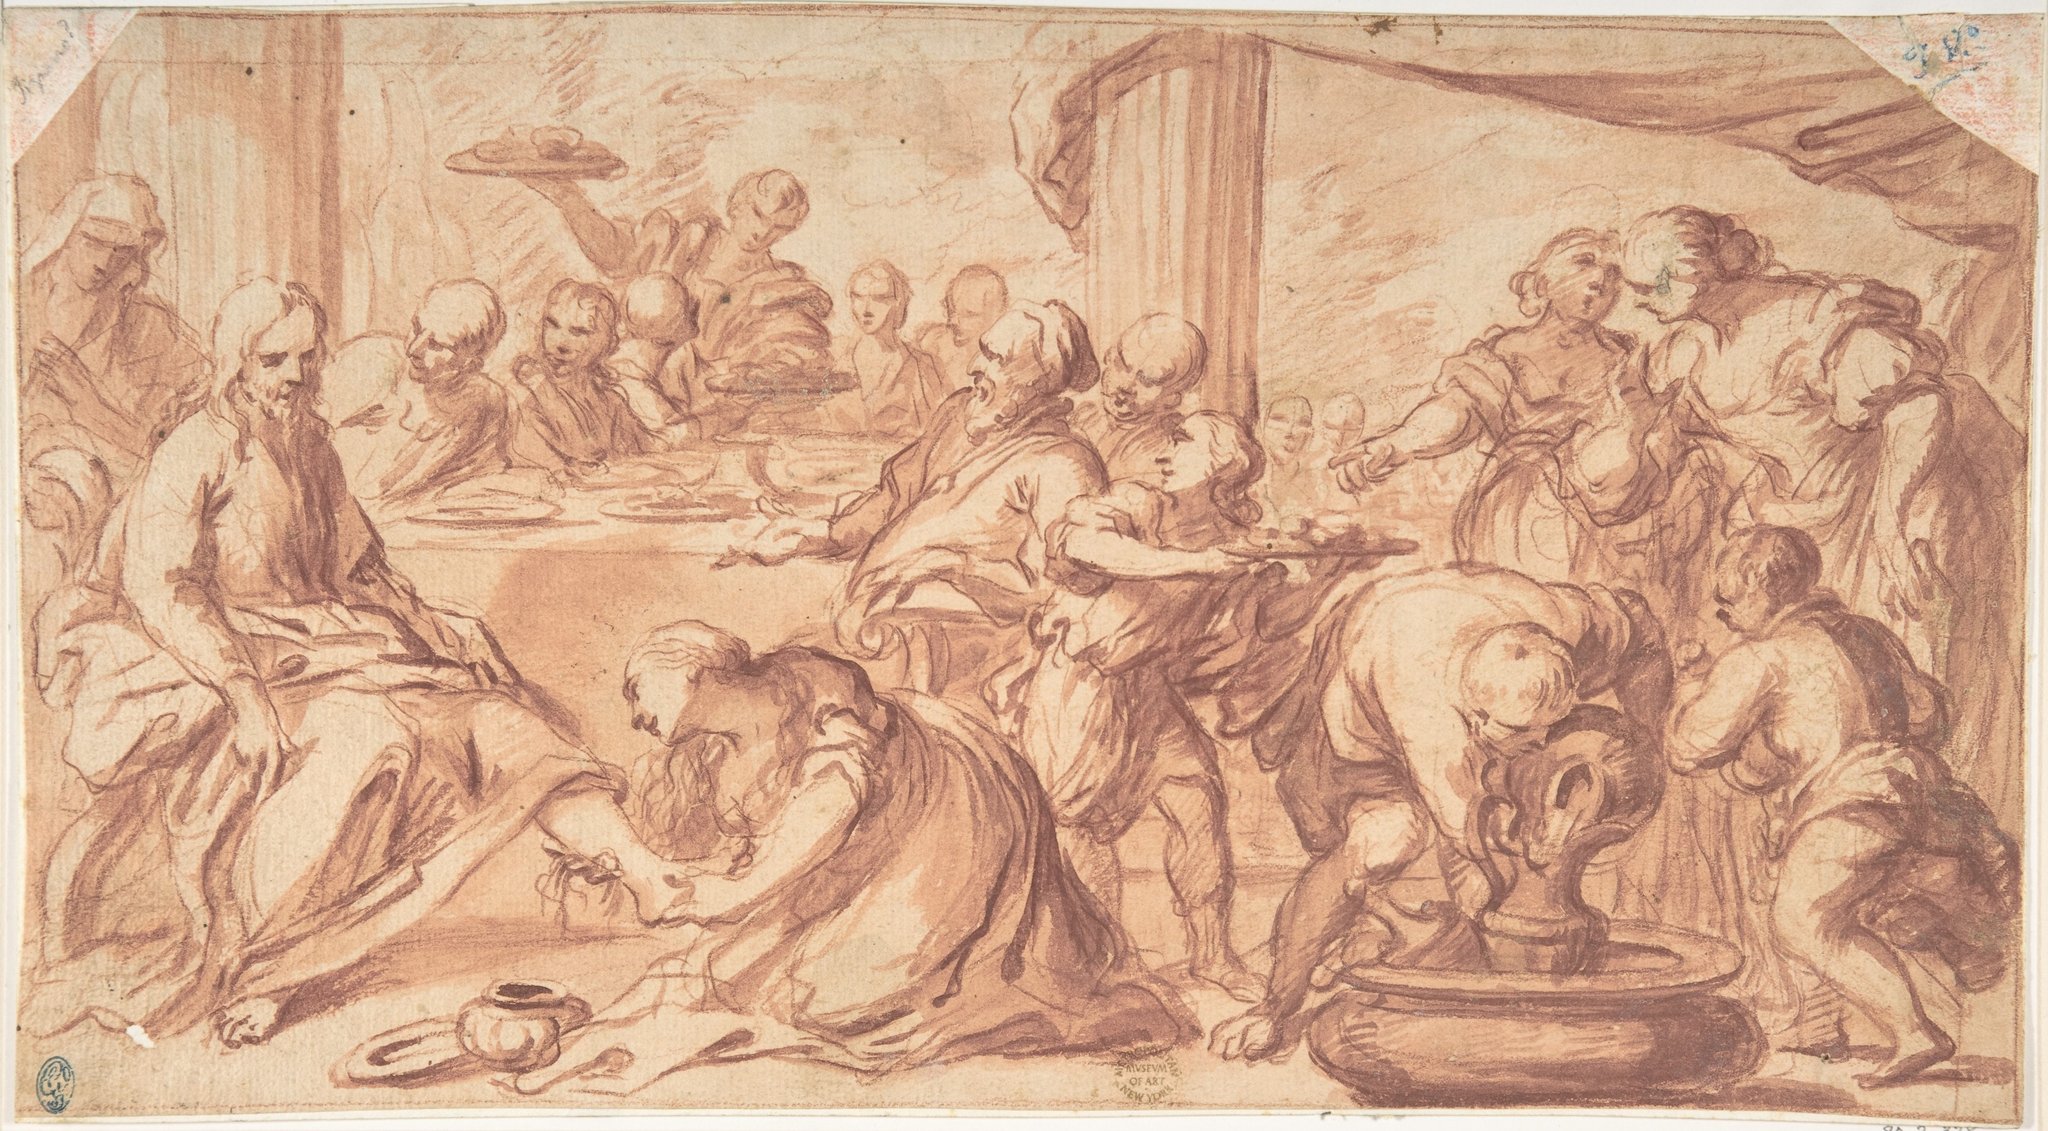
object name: drawing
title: Mary Magdalen Washing Christ's Feet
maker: anonymous, italian, roman-bolognese, 17th century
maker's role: artist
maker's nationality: italian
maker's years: 1600-1700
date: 1601-1700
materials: chalk, paper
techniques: brush, wash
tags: feet,men,women,christ,mary magdalene